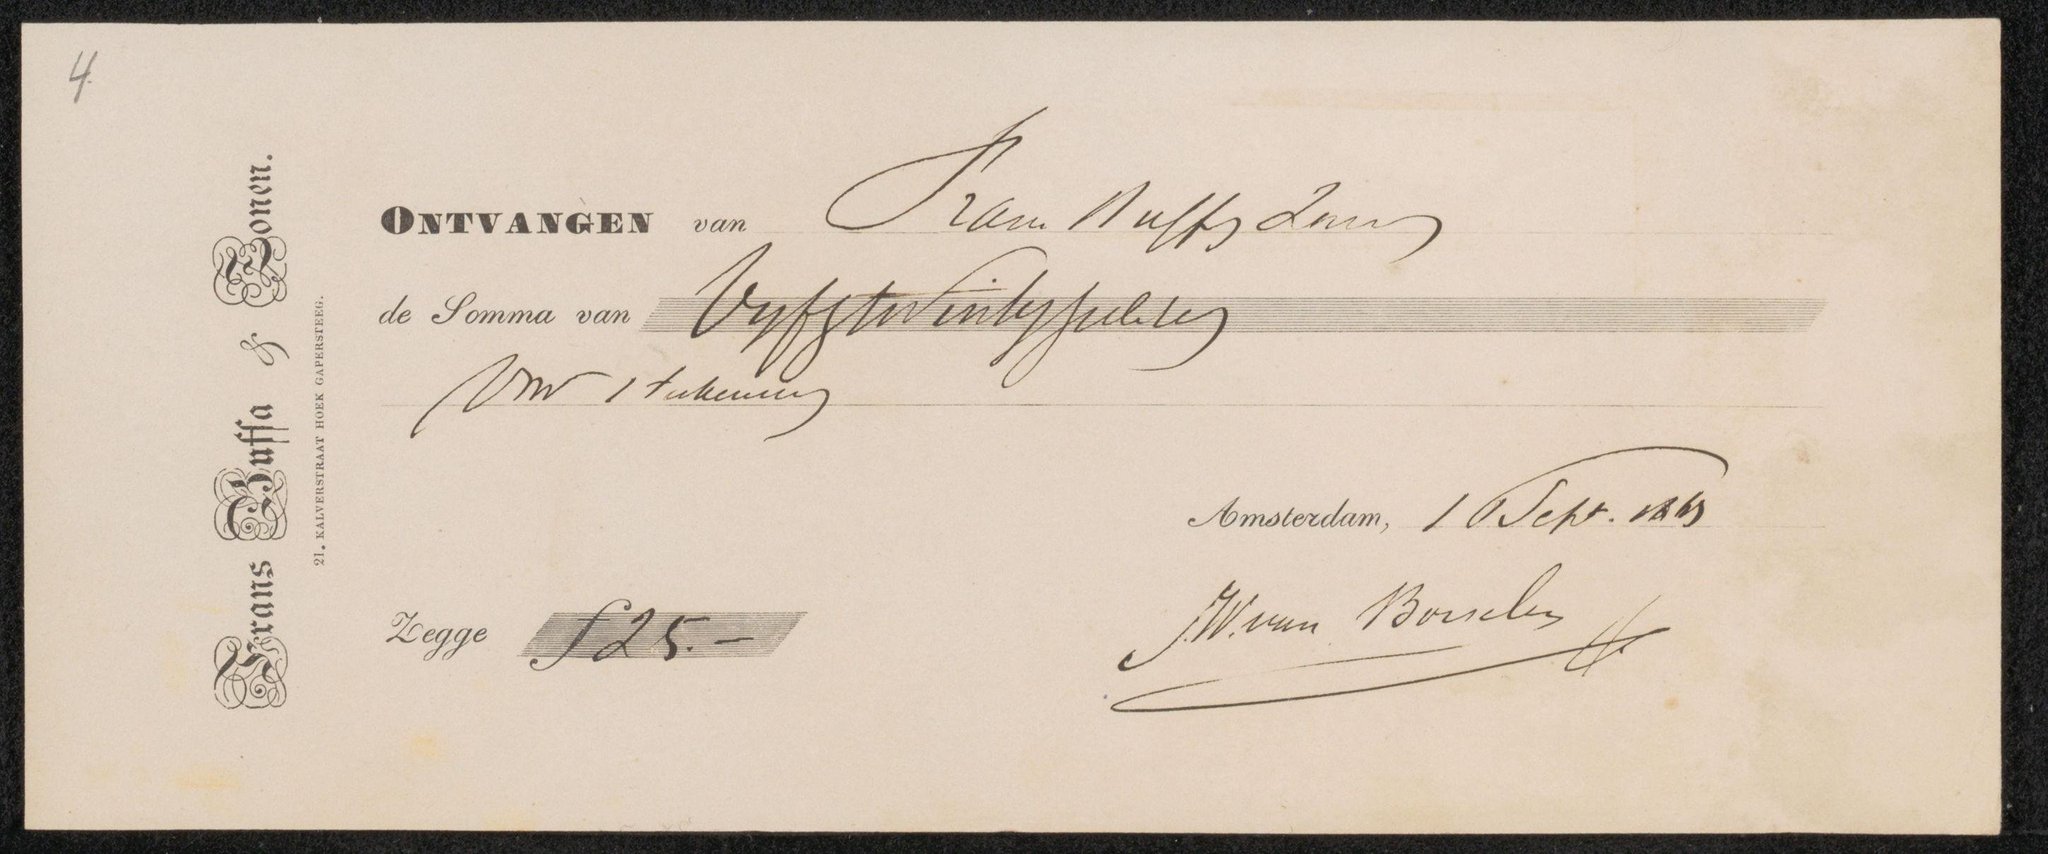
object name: ontvangstbewijs, kwitantie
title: Kwitantie voor Jan Willem van Borselen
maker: jan willem van borselen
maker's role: draughtsman, print maker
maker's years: 1825-1892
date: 1863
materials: ink, paper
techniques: pen, printing, writing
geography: amsterdam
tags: drawing, money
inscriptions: collector's mark: Lugt 2233